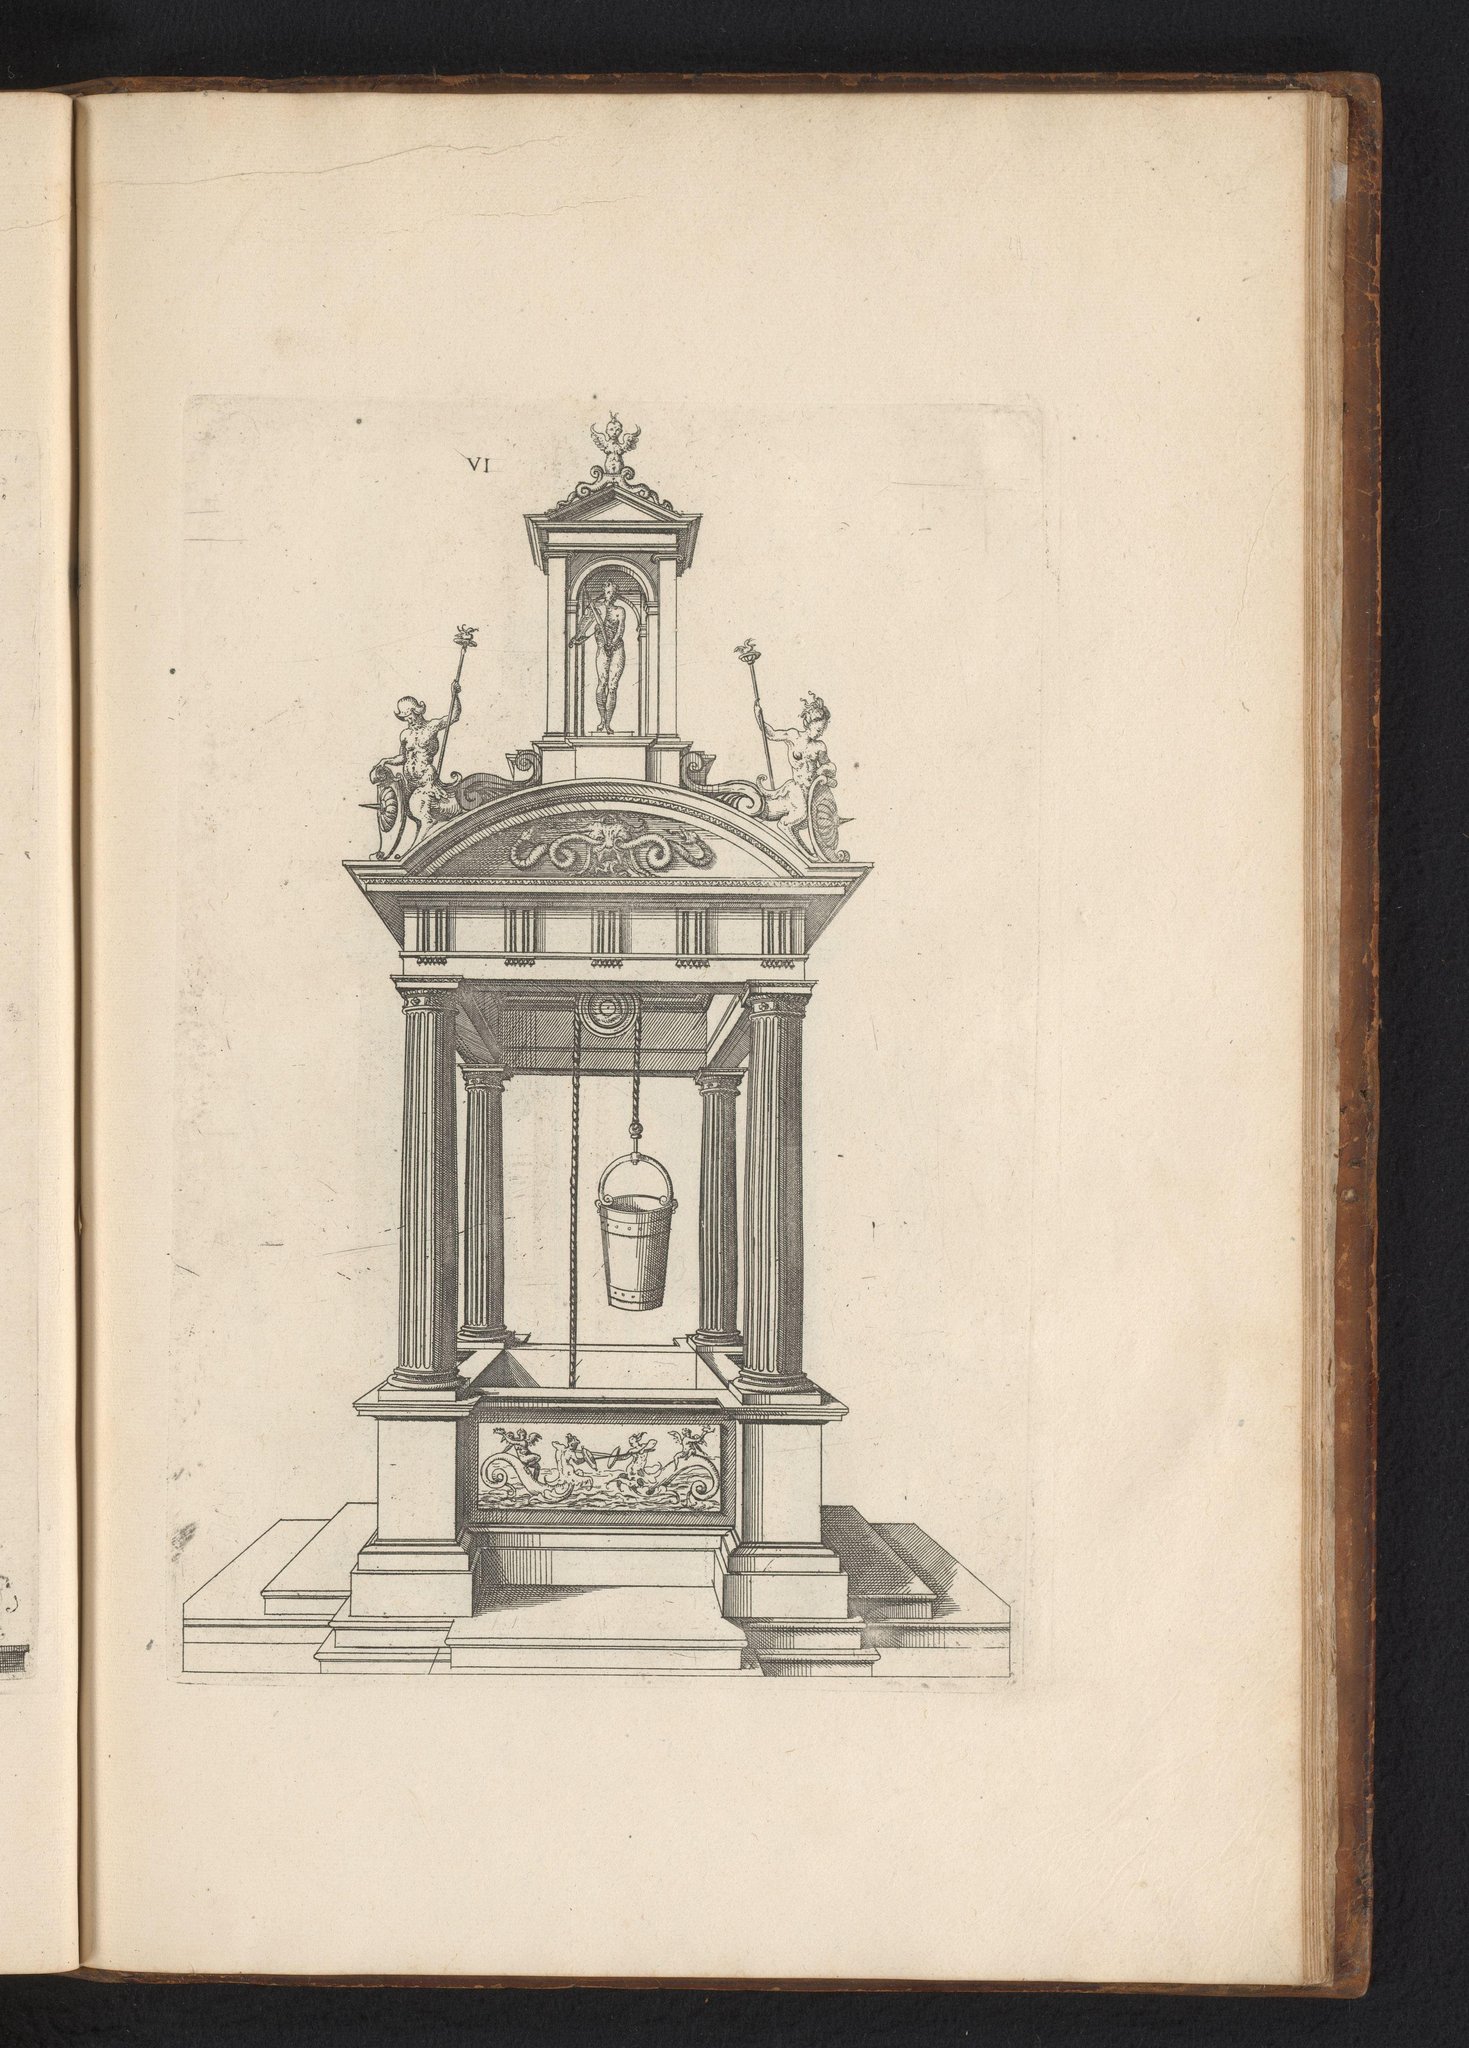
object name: ornament print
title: Waterput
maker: jacques androuet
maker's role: draughtsman, print maker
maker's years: 1515-1584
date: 1561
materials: paper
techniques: etching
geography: paris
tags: well, architectural design or model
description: Waterput. Onderdeel van 'Seconde livre d'architectvre' (1561): 64 etsen met geornamenteerde architectuuronderdelen.